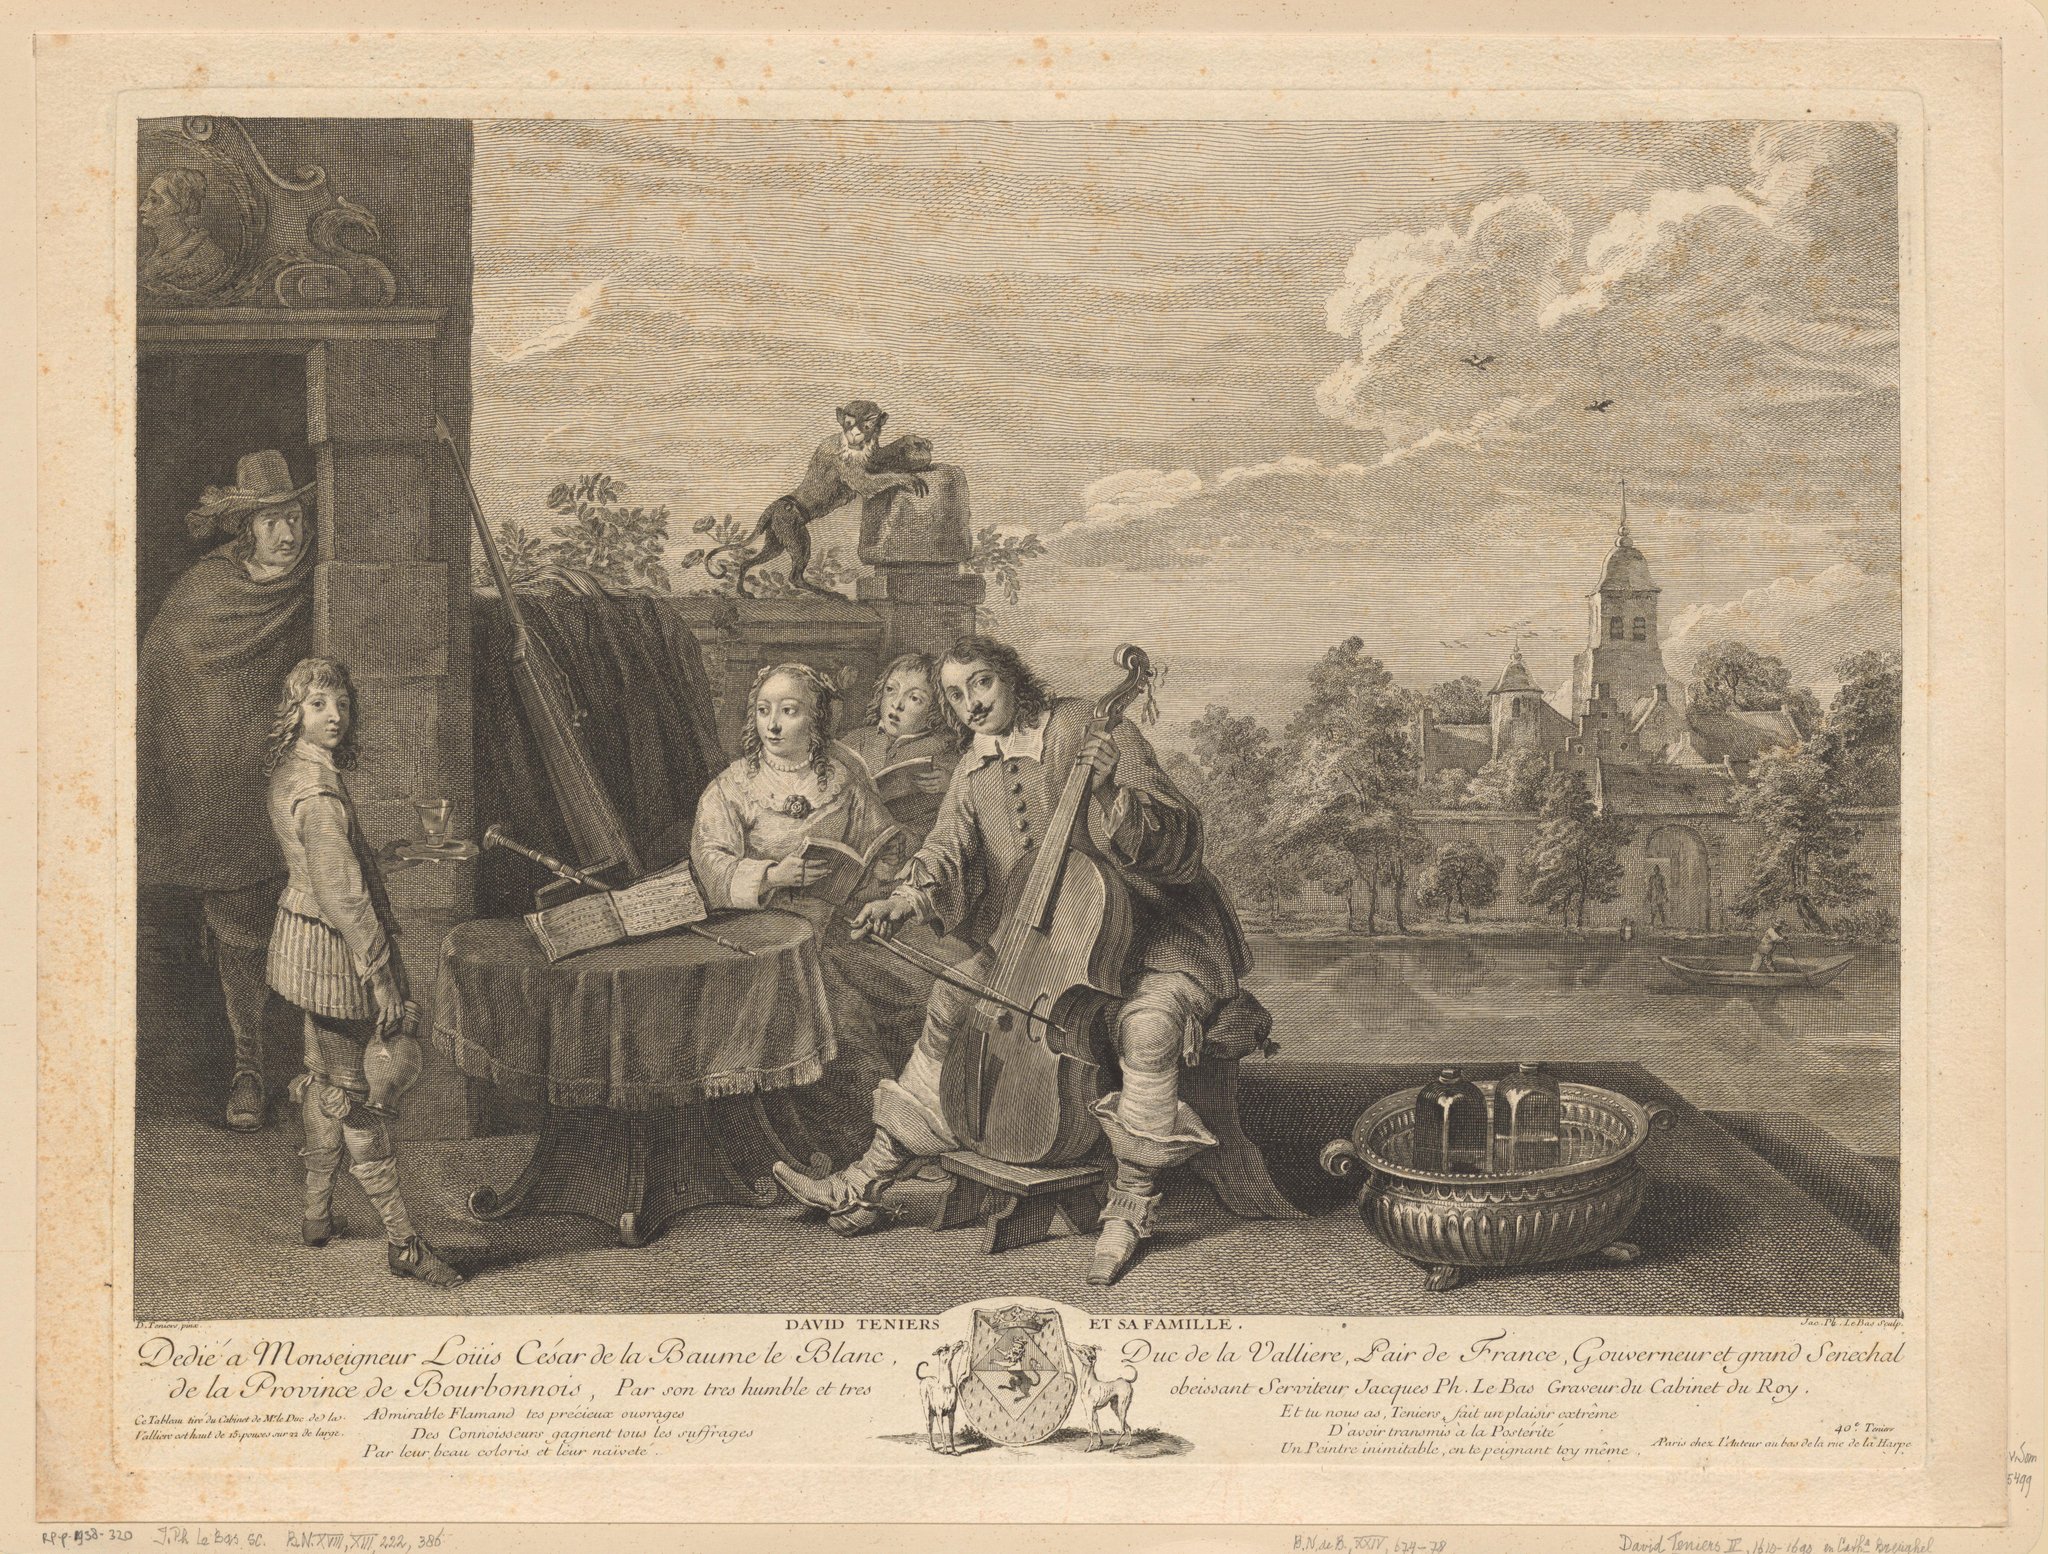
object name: print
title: David Teniers et sa Famille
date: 1747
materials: paper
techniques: engraving, etching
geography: paris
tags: antwerp, brussels, painter, david teniers (ii), historical persons, portrait, self-portrait of artist, more than one musician with instrument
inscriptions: collector's mark: Lugt 2228